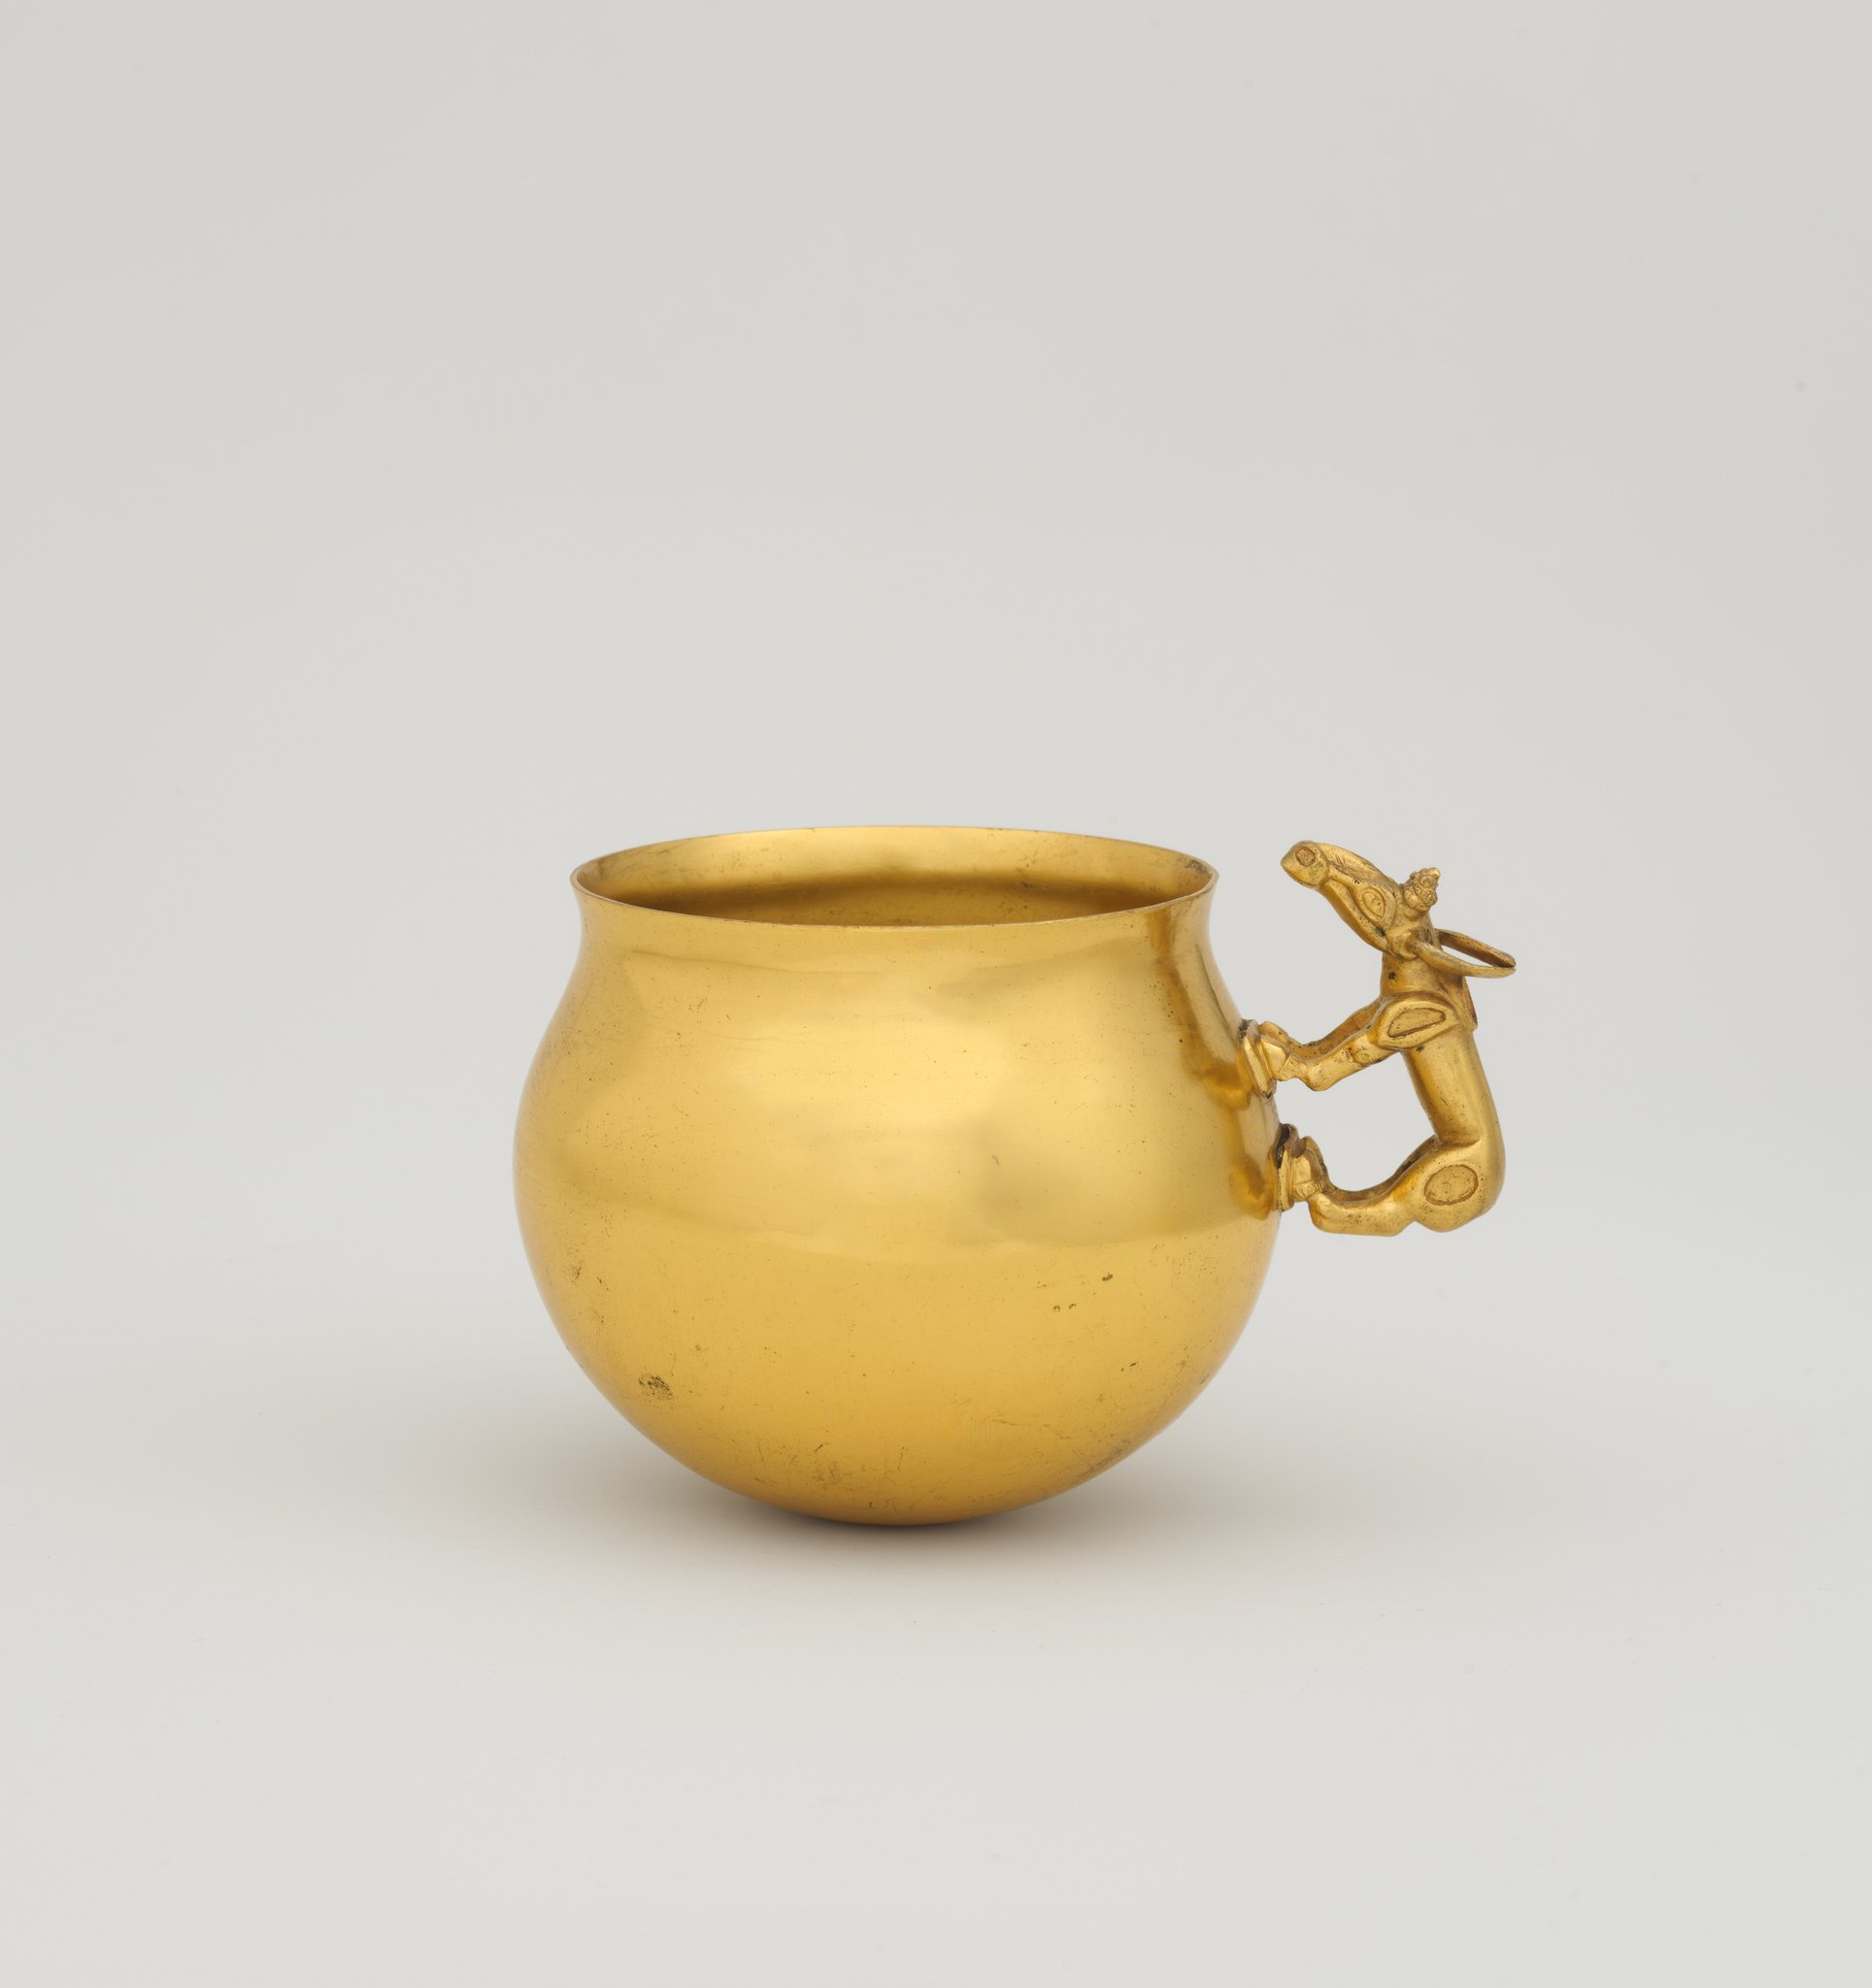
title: Reproduction of a Sarmatian cup with animal handle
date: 1801-1900